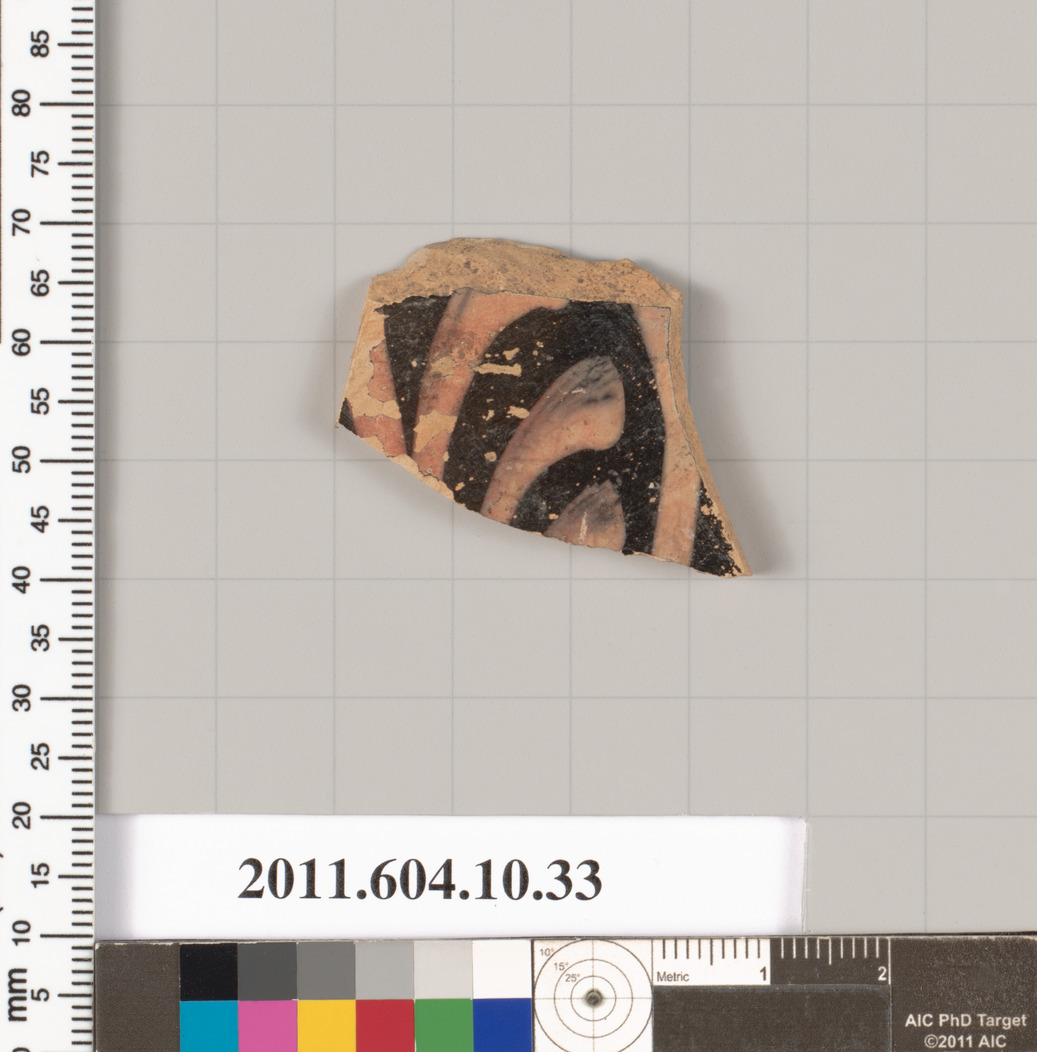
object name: kylix fragment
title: Terracotta fragment of a kylix (drinking cup)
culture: etruscan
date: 434-368 BCE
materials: terracotta